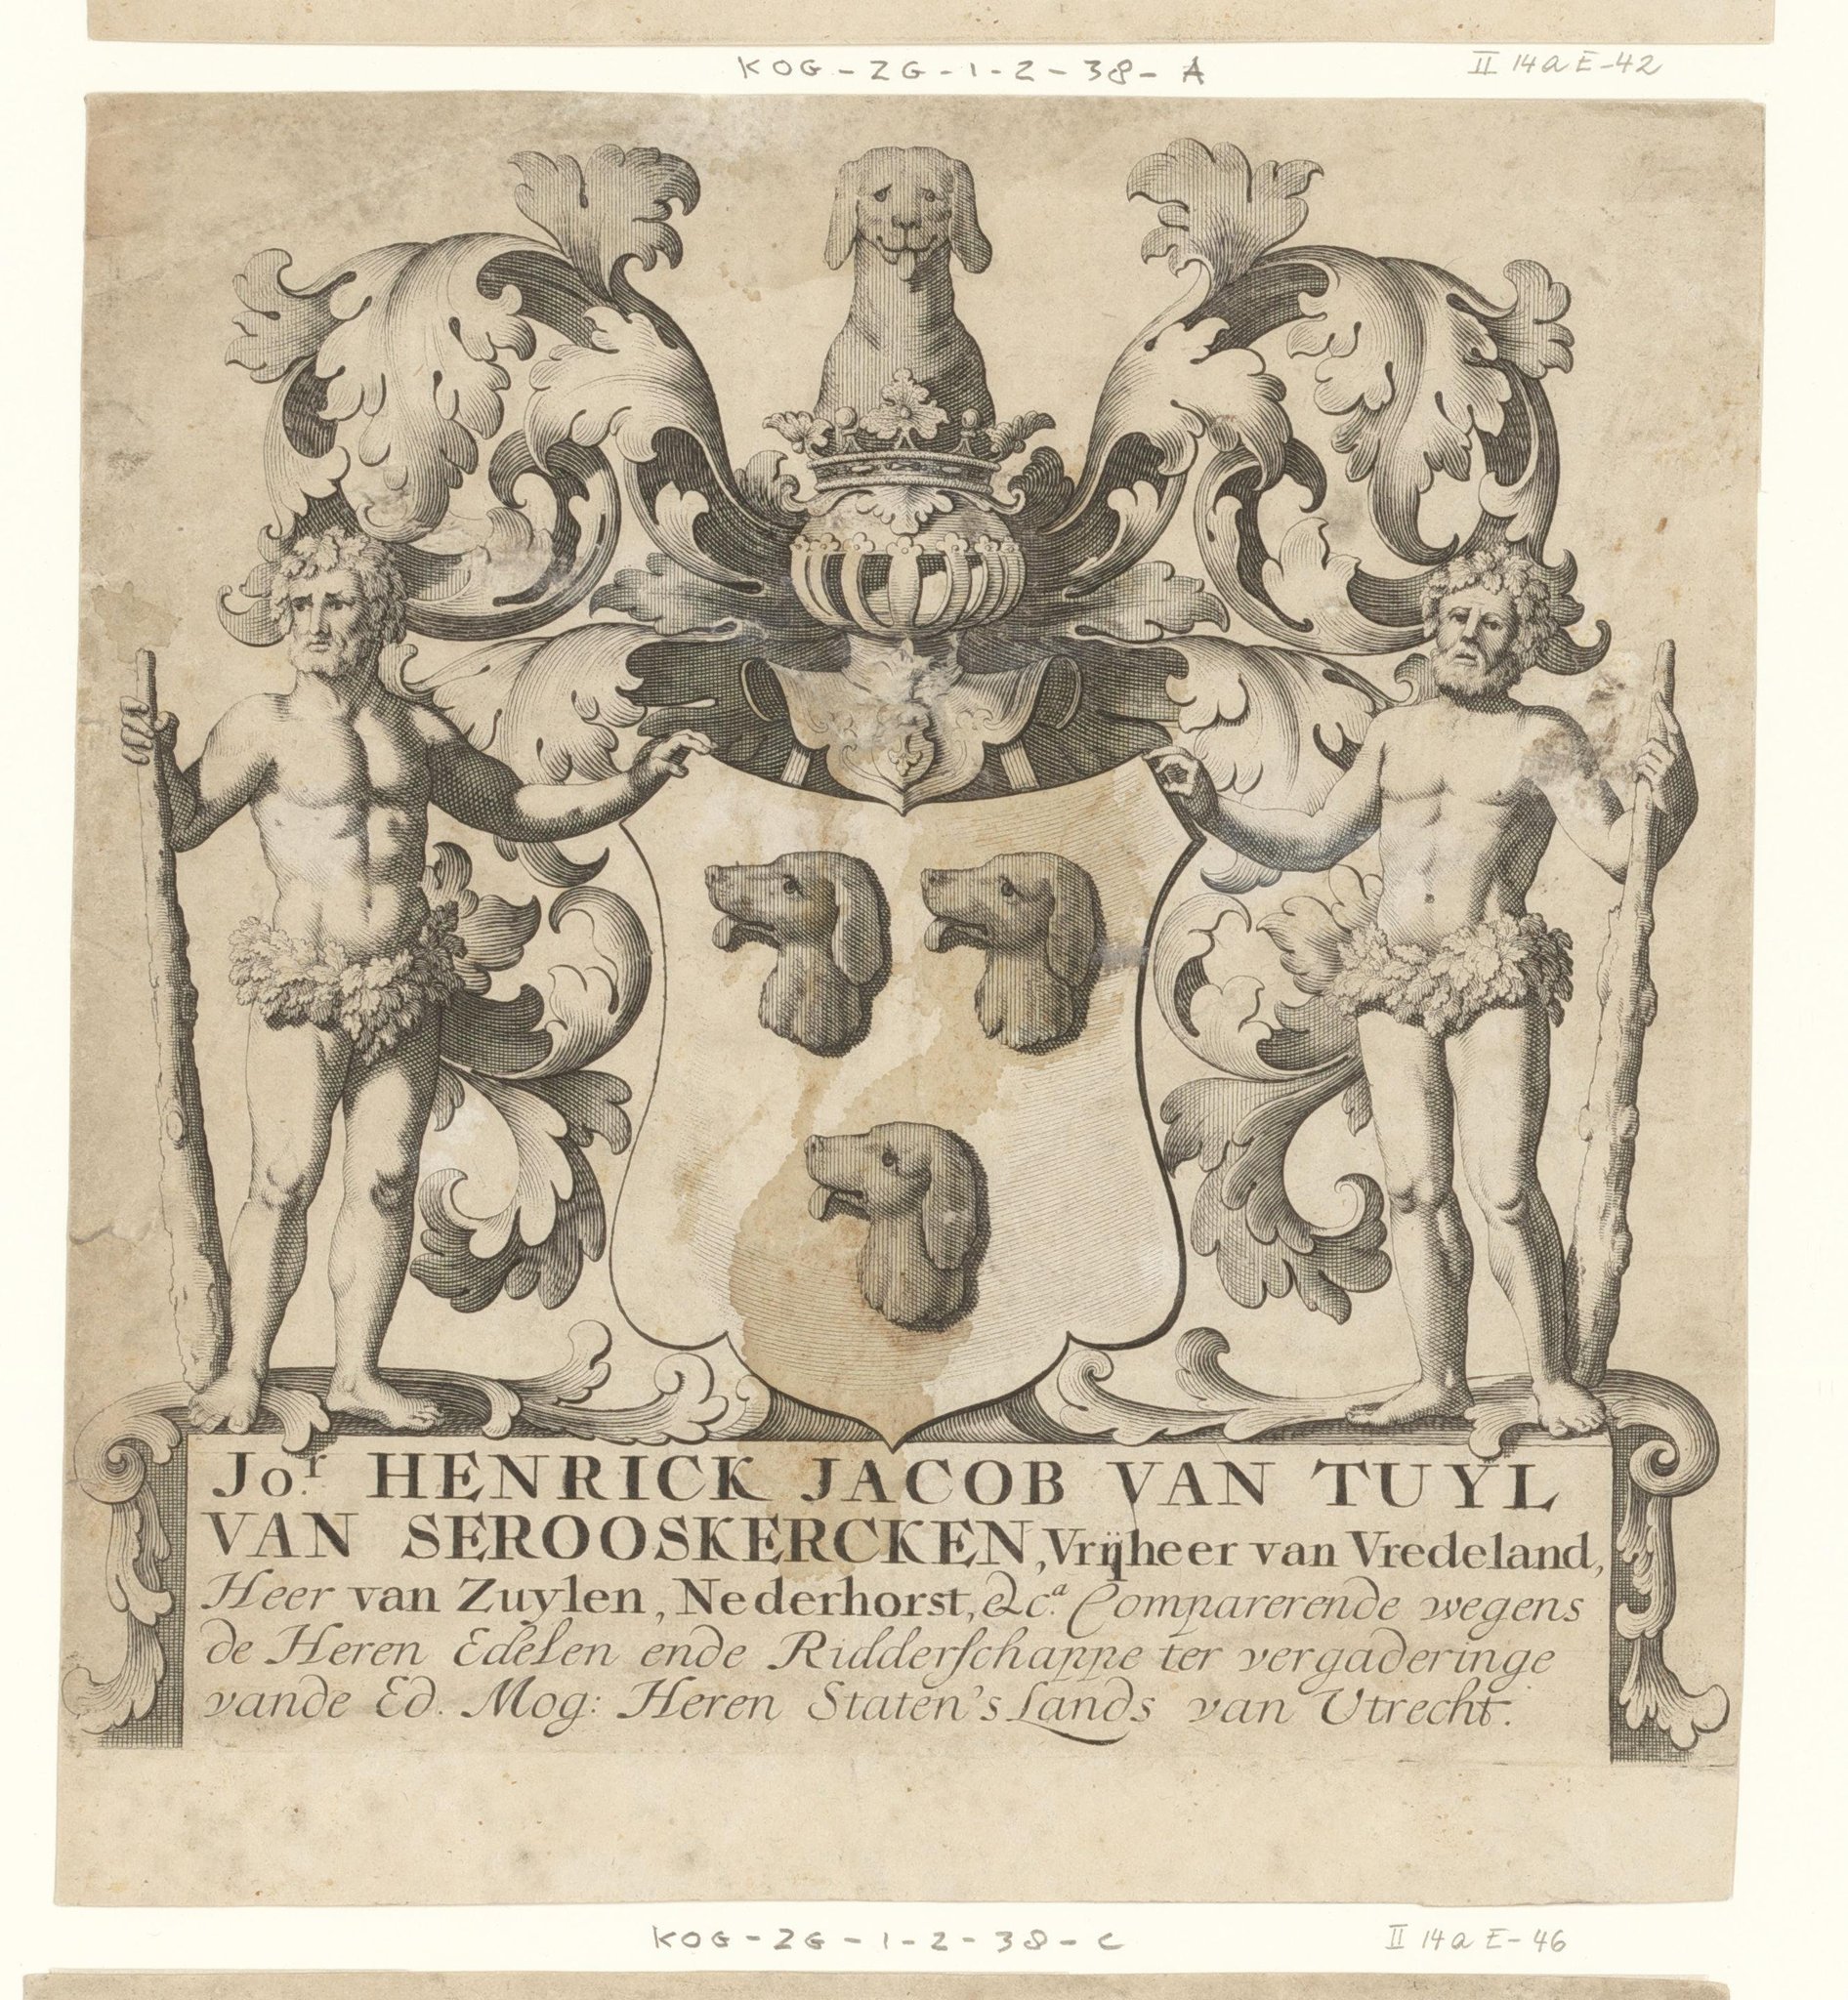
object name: print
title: Familiewapen van Jhr. Henrick Jacob van Tuyl van Serooskercken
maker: Anonymous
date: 1689-1690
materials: paper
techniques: engraving, etching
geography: netherlands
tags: armorial bearing, heraldry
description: Familiewapen van Jhr. Henrick Jacob van Tuyl van Serooskercken, vrijheer van Vredeland. Onderdeel van een groep van twaalf wapens van magistraten van Utrecht. Mogelijk behorend bij een grote kaart van bijvoorbeeld een hoogheemraadschap. Onderwerpsrubrieken binnen de Atlas Zeden en Gewoonten: Regeering, Wapens (Heraldiek), Geslachtswapens.